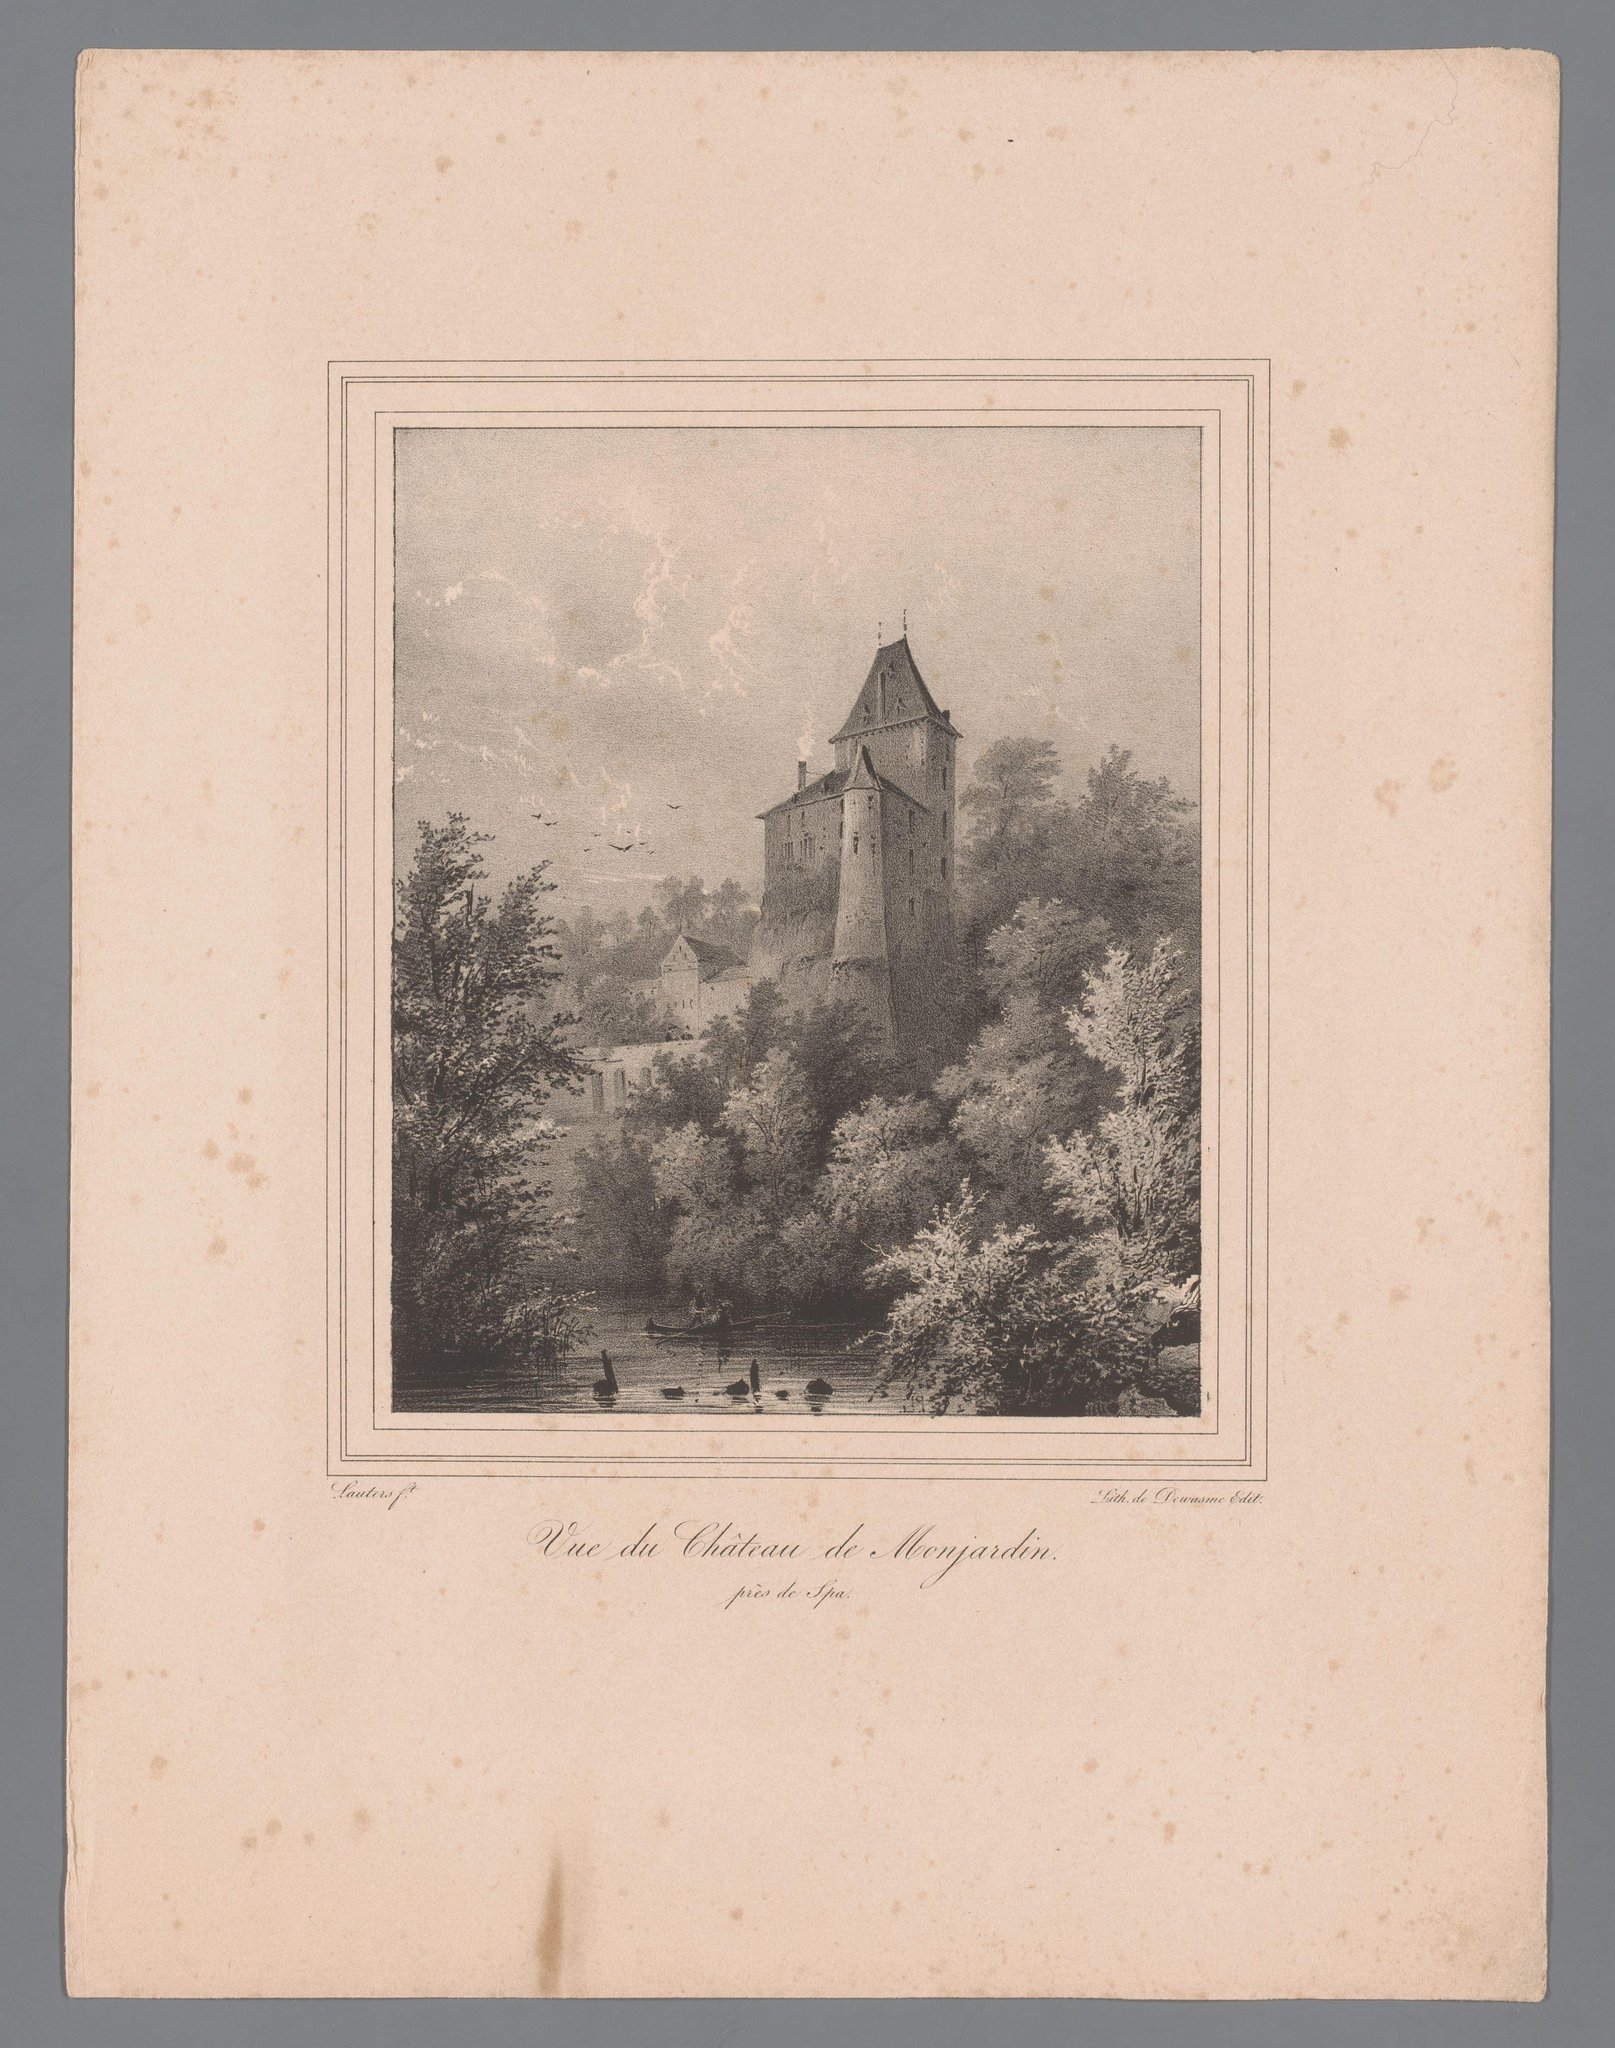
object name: print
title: Gezicht op het kasteel van Montjardin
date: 1816-1851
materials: paper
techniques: lithograph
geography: brussels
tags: landscape with tower or castle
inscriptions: collector's mark: Lugt 2228